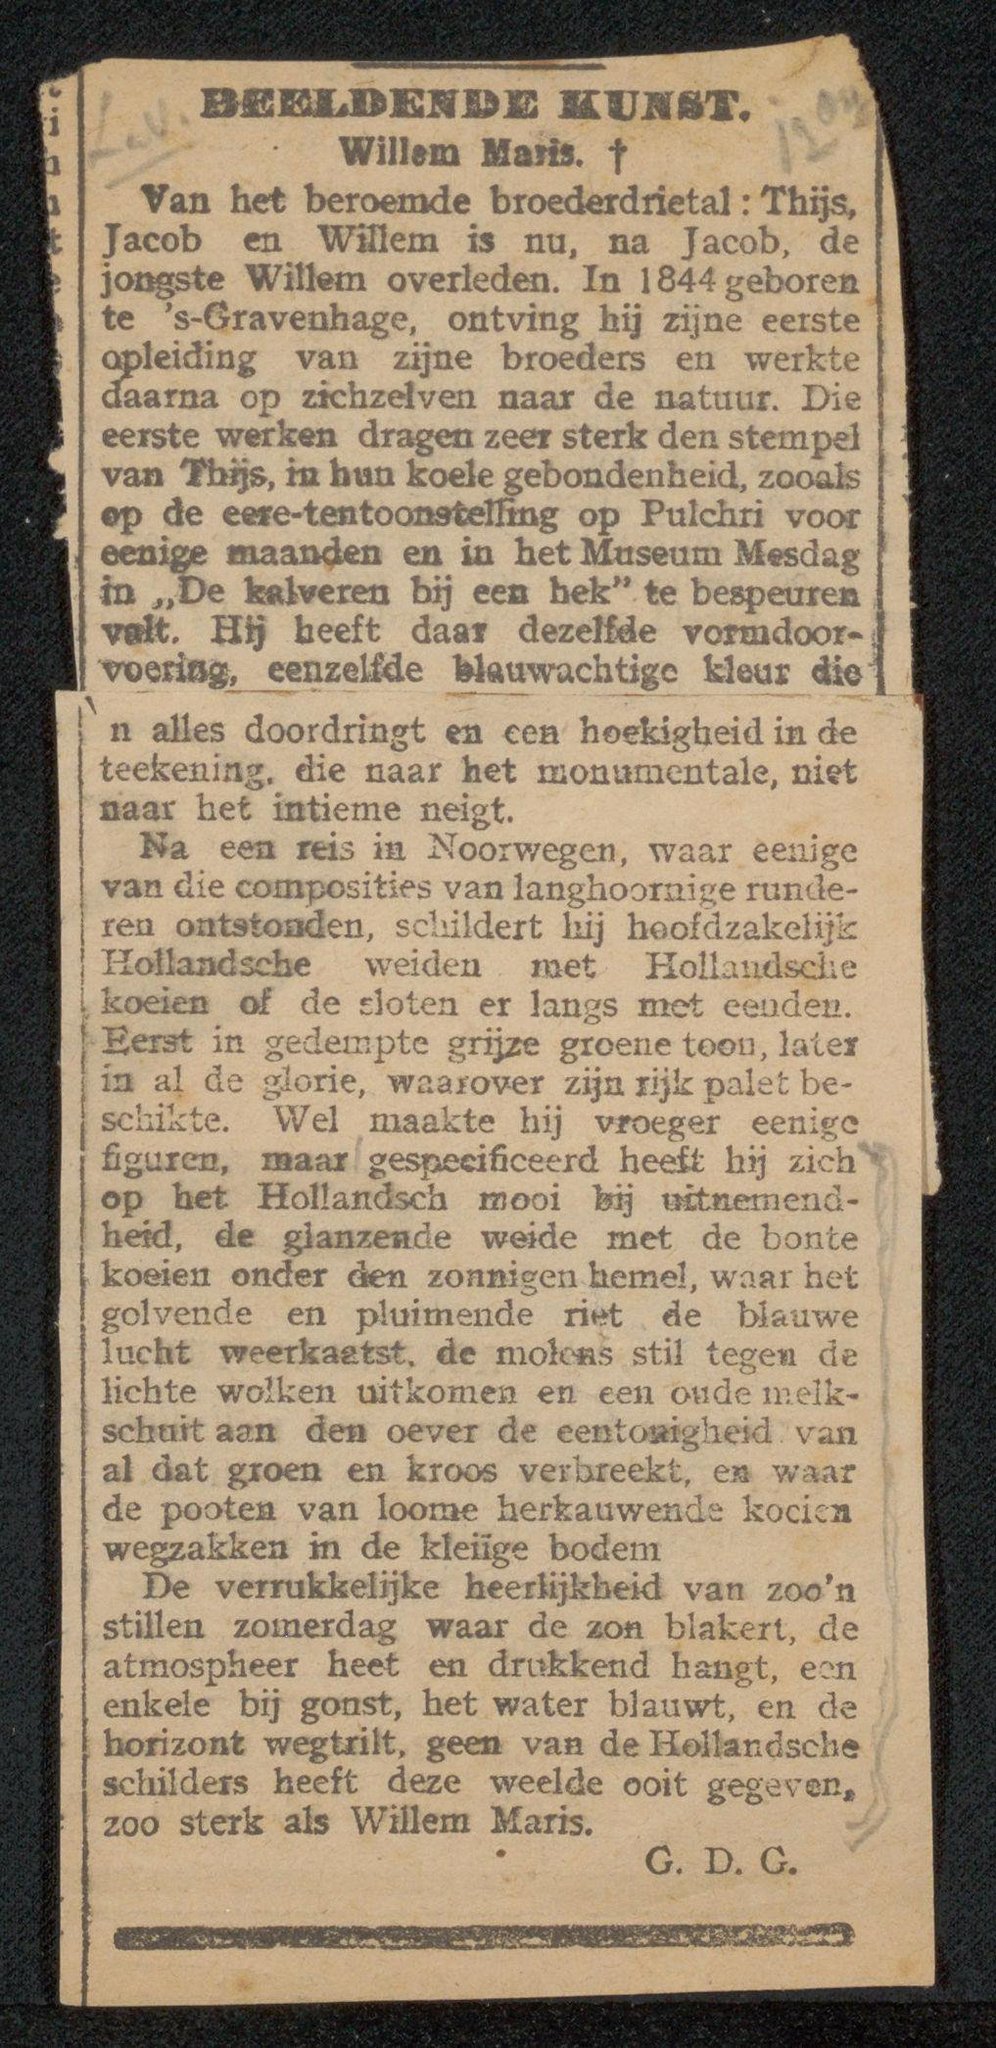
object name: newspaper clipping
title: Krantenknipsel uit archief Philip Zilcken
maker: Anonymous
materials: paper, ink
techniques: printing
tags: the hague, painter, draughtsman, willem maris, philip zilcken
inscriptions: collector's mark: ‘RPK’